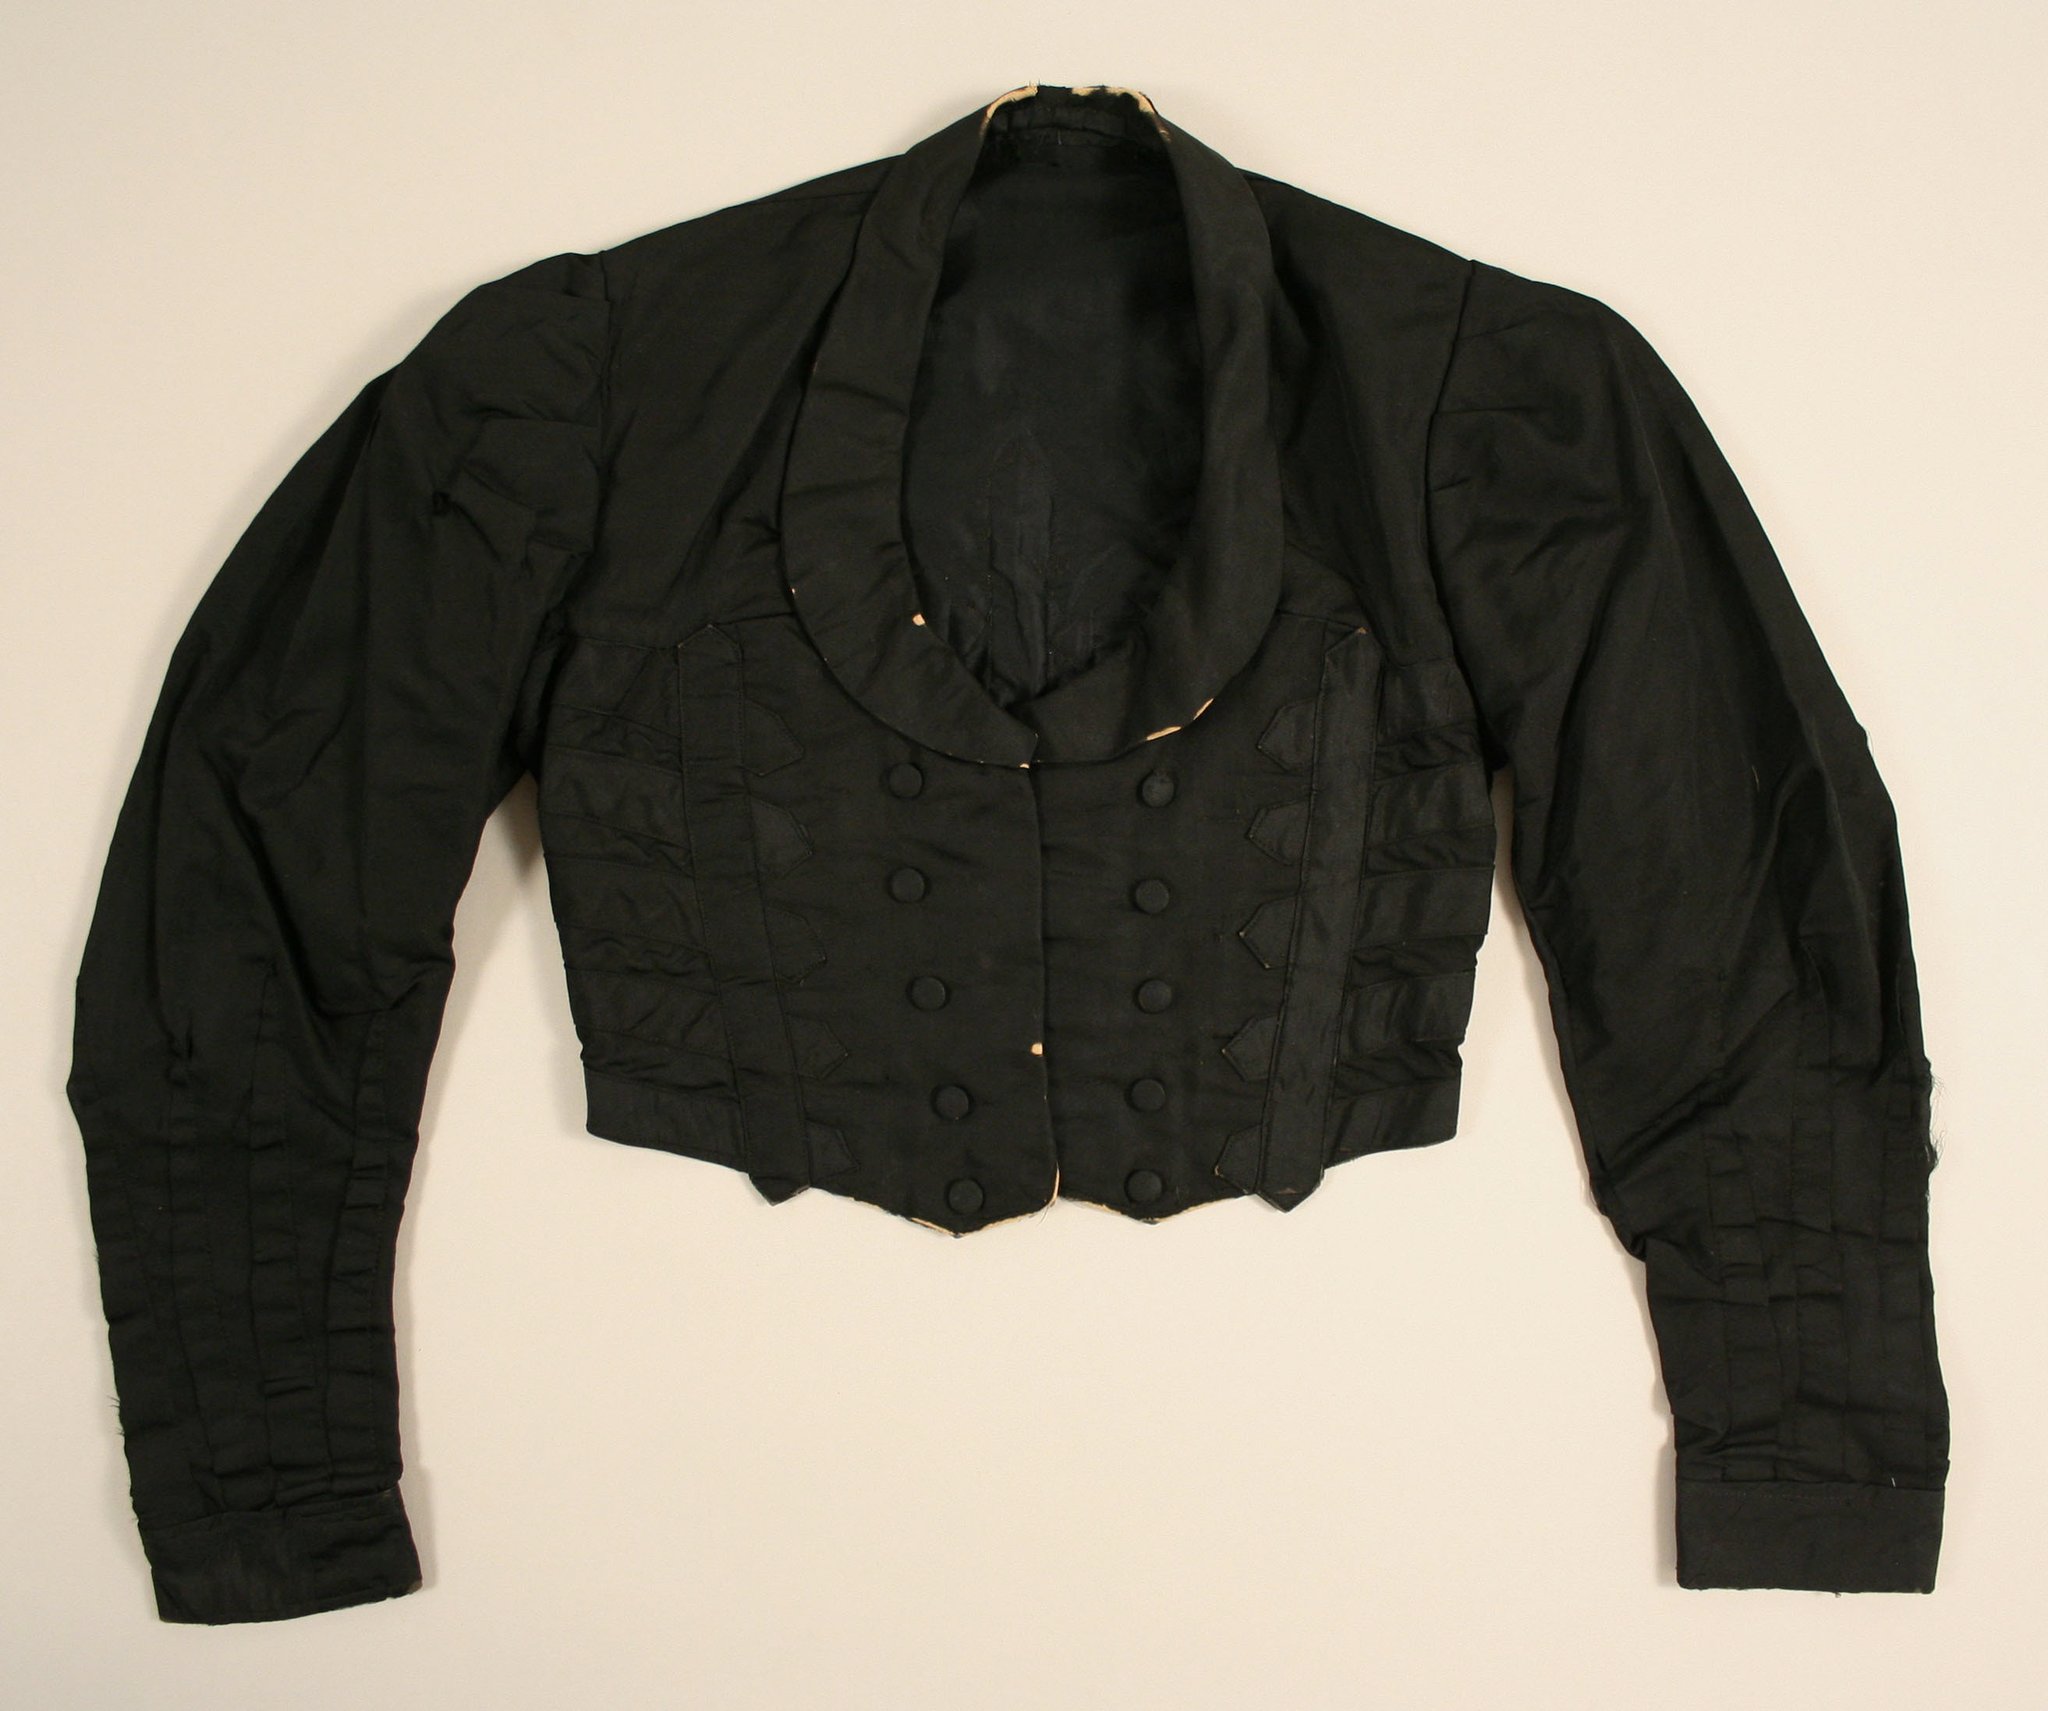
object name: spencer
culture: american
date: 1818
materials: silk